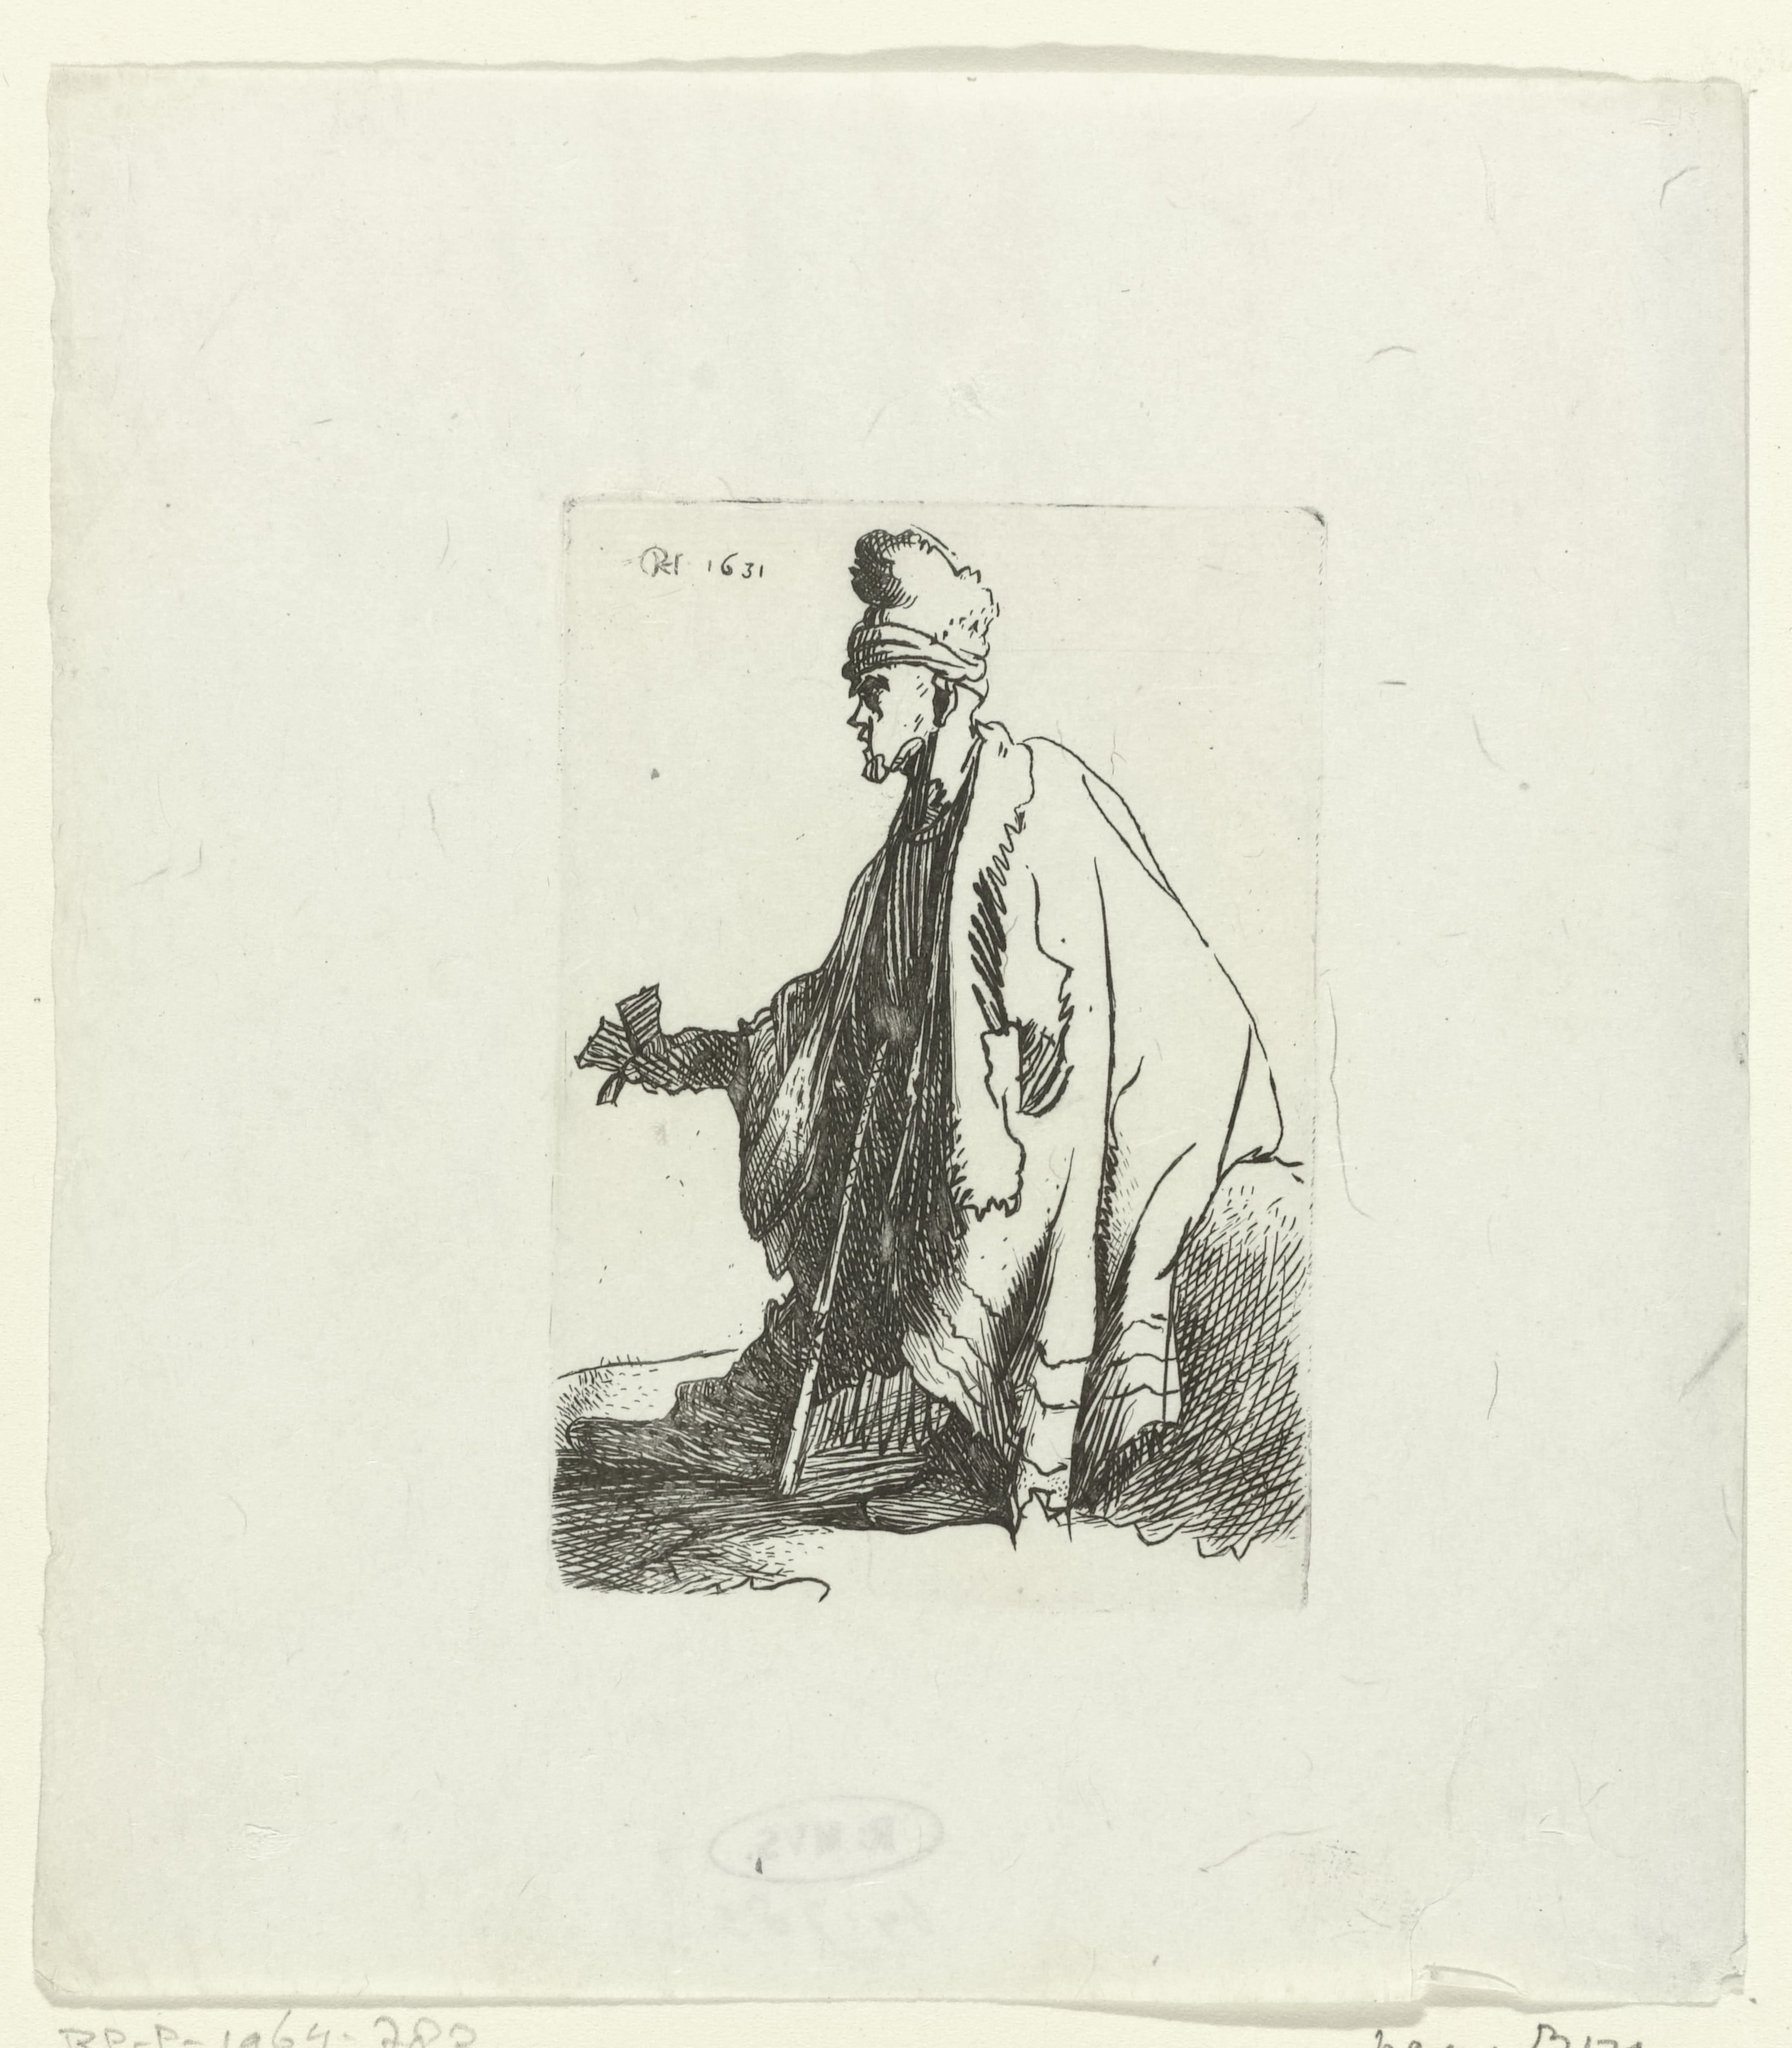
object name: print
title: Twaalf etsen naar Rembrandt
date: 1824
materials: paper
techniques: etching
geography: london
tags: walking-stick, staff, leprosy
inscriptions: collector's mark: Lugt 2228